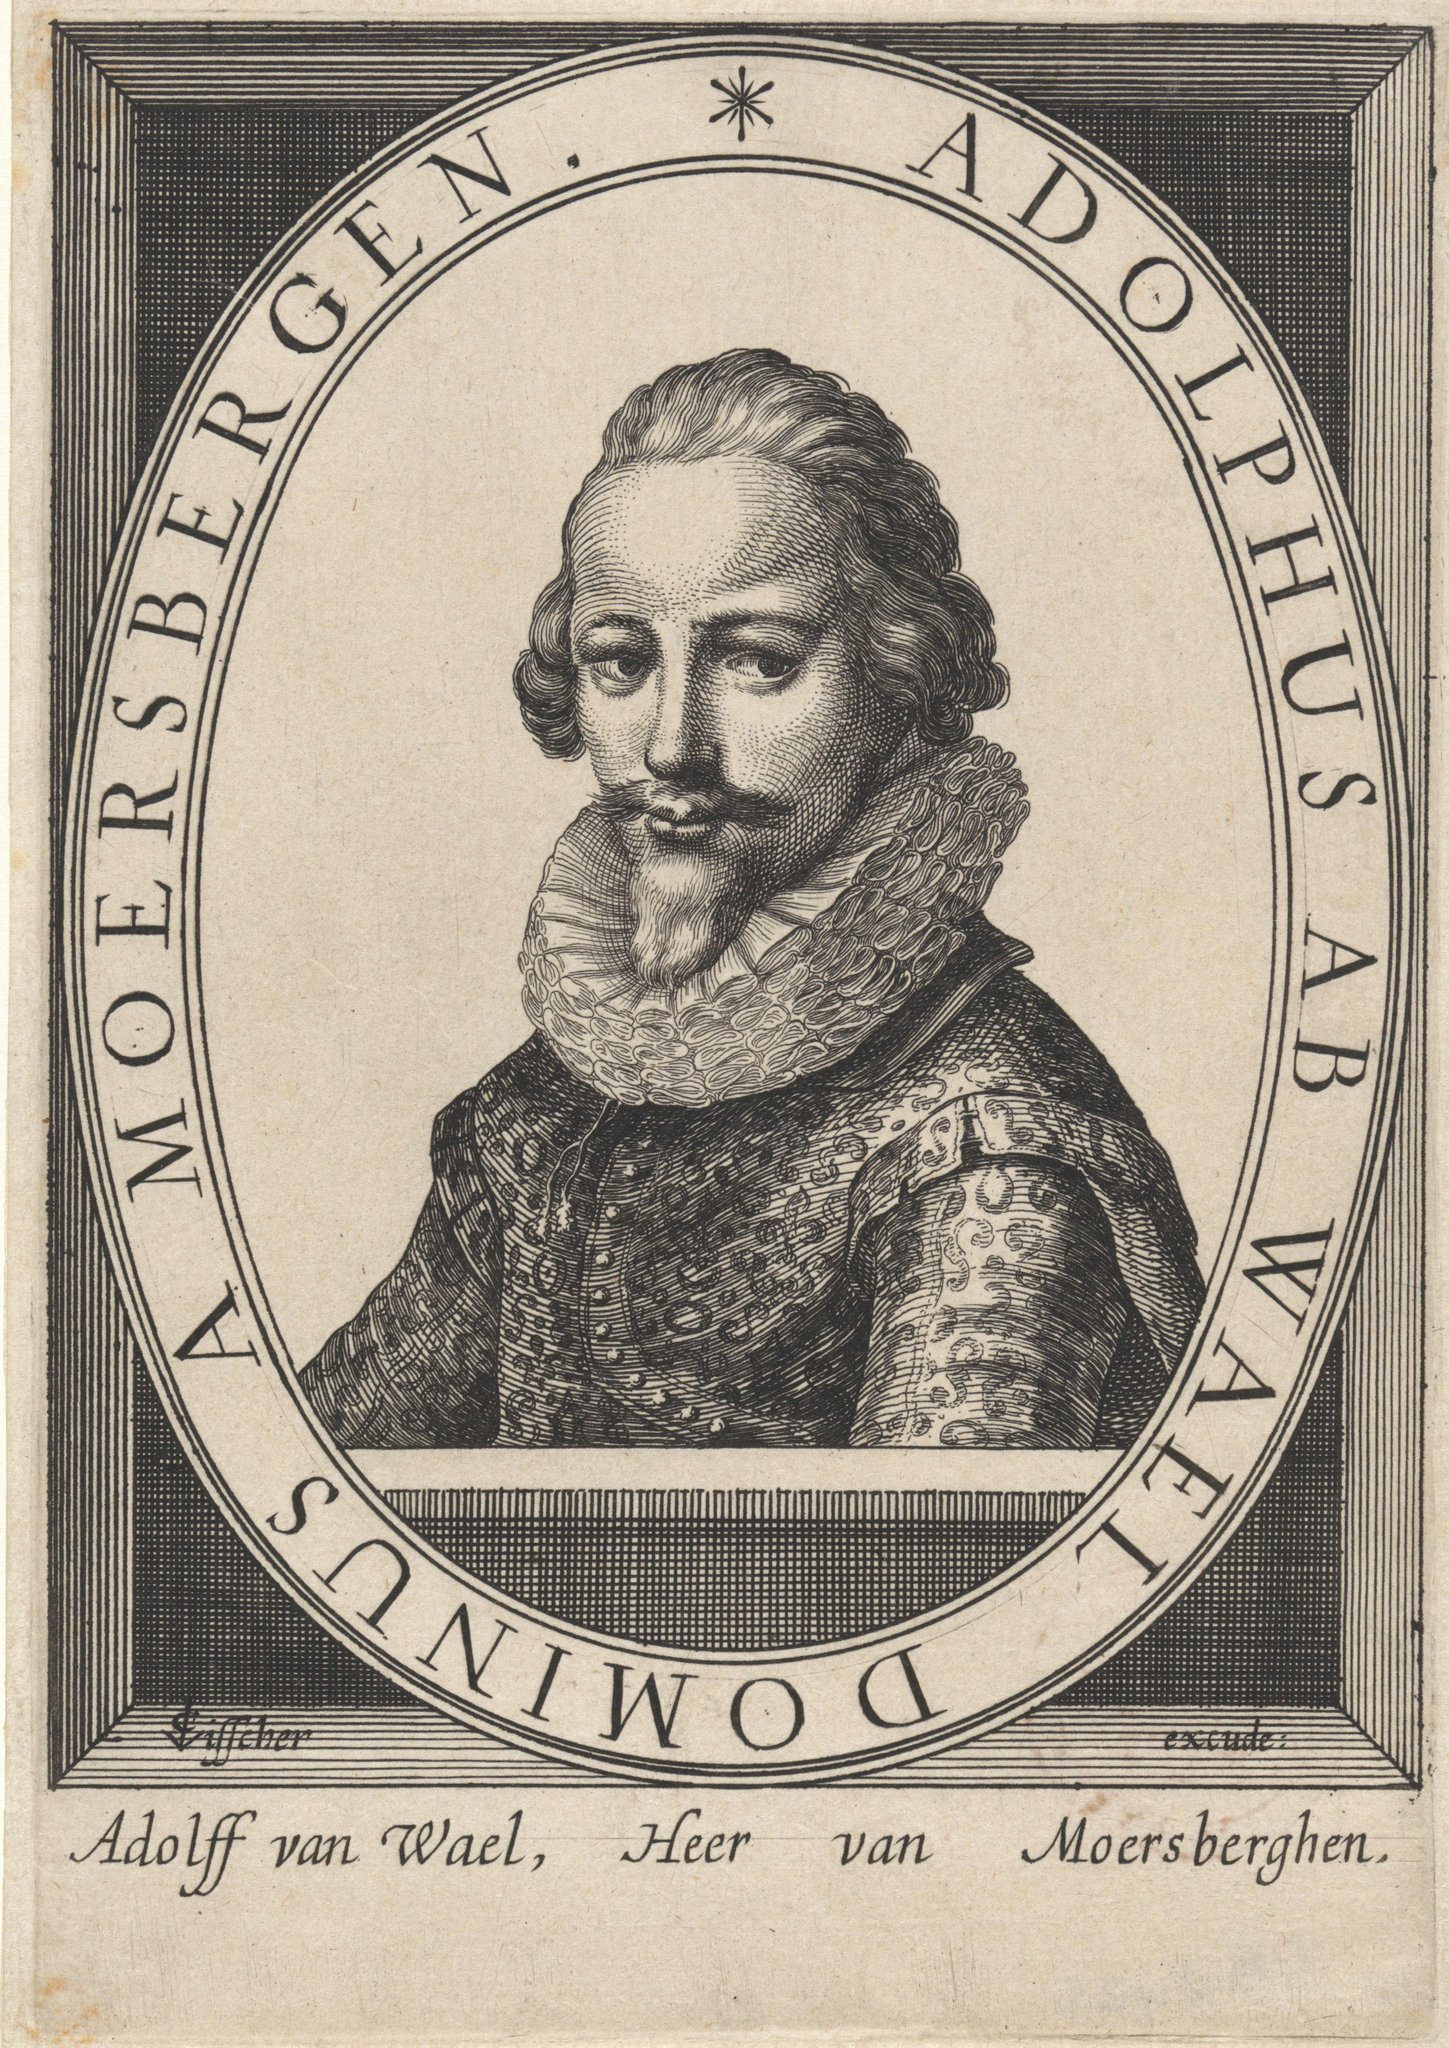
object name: print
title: Portret van Adolf de Wael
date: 1619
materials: paper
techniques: engraving, etching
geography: amsterdam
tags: mayor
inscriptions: collector's mark: Lugt 2228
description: Portret van Adolf de Wael, heer van Moersbergen. Hij was lid van de Ridderschap van Utrecht en burgemeester van Utrecht. Zijn portret is gevat in een ovale omlijsting waarin zijn naam en functie.